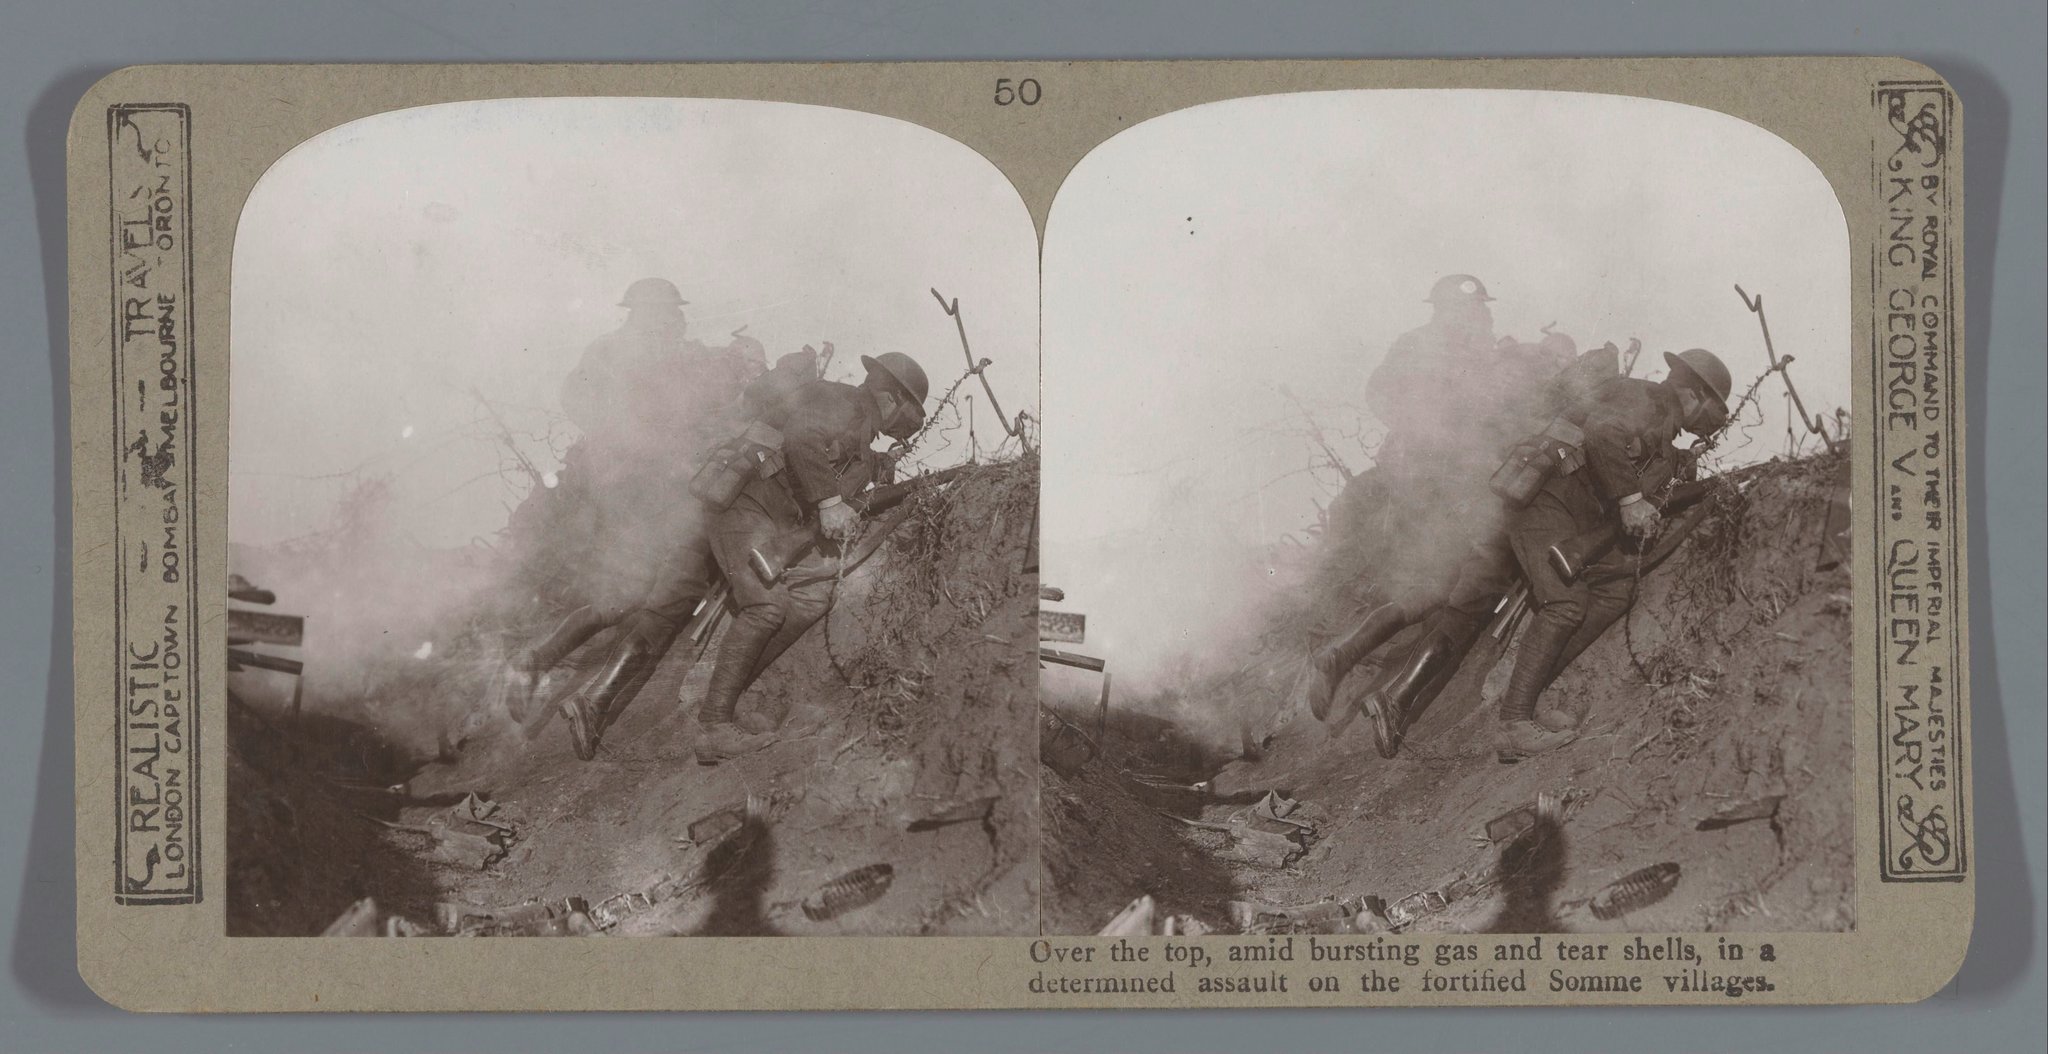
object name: stereograph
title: Over the top, amid bursting gas and tear shells, in a determined assault on the fortified Somme villages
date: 1914-1918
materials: cardboard, photographic support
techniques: gelatin silver print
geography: pas-de-calais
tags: private soldier, trenches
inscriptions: inscription: ‘By Royal command to their Imperial majesties King George V and Queen Mary’, number: ‘50’